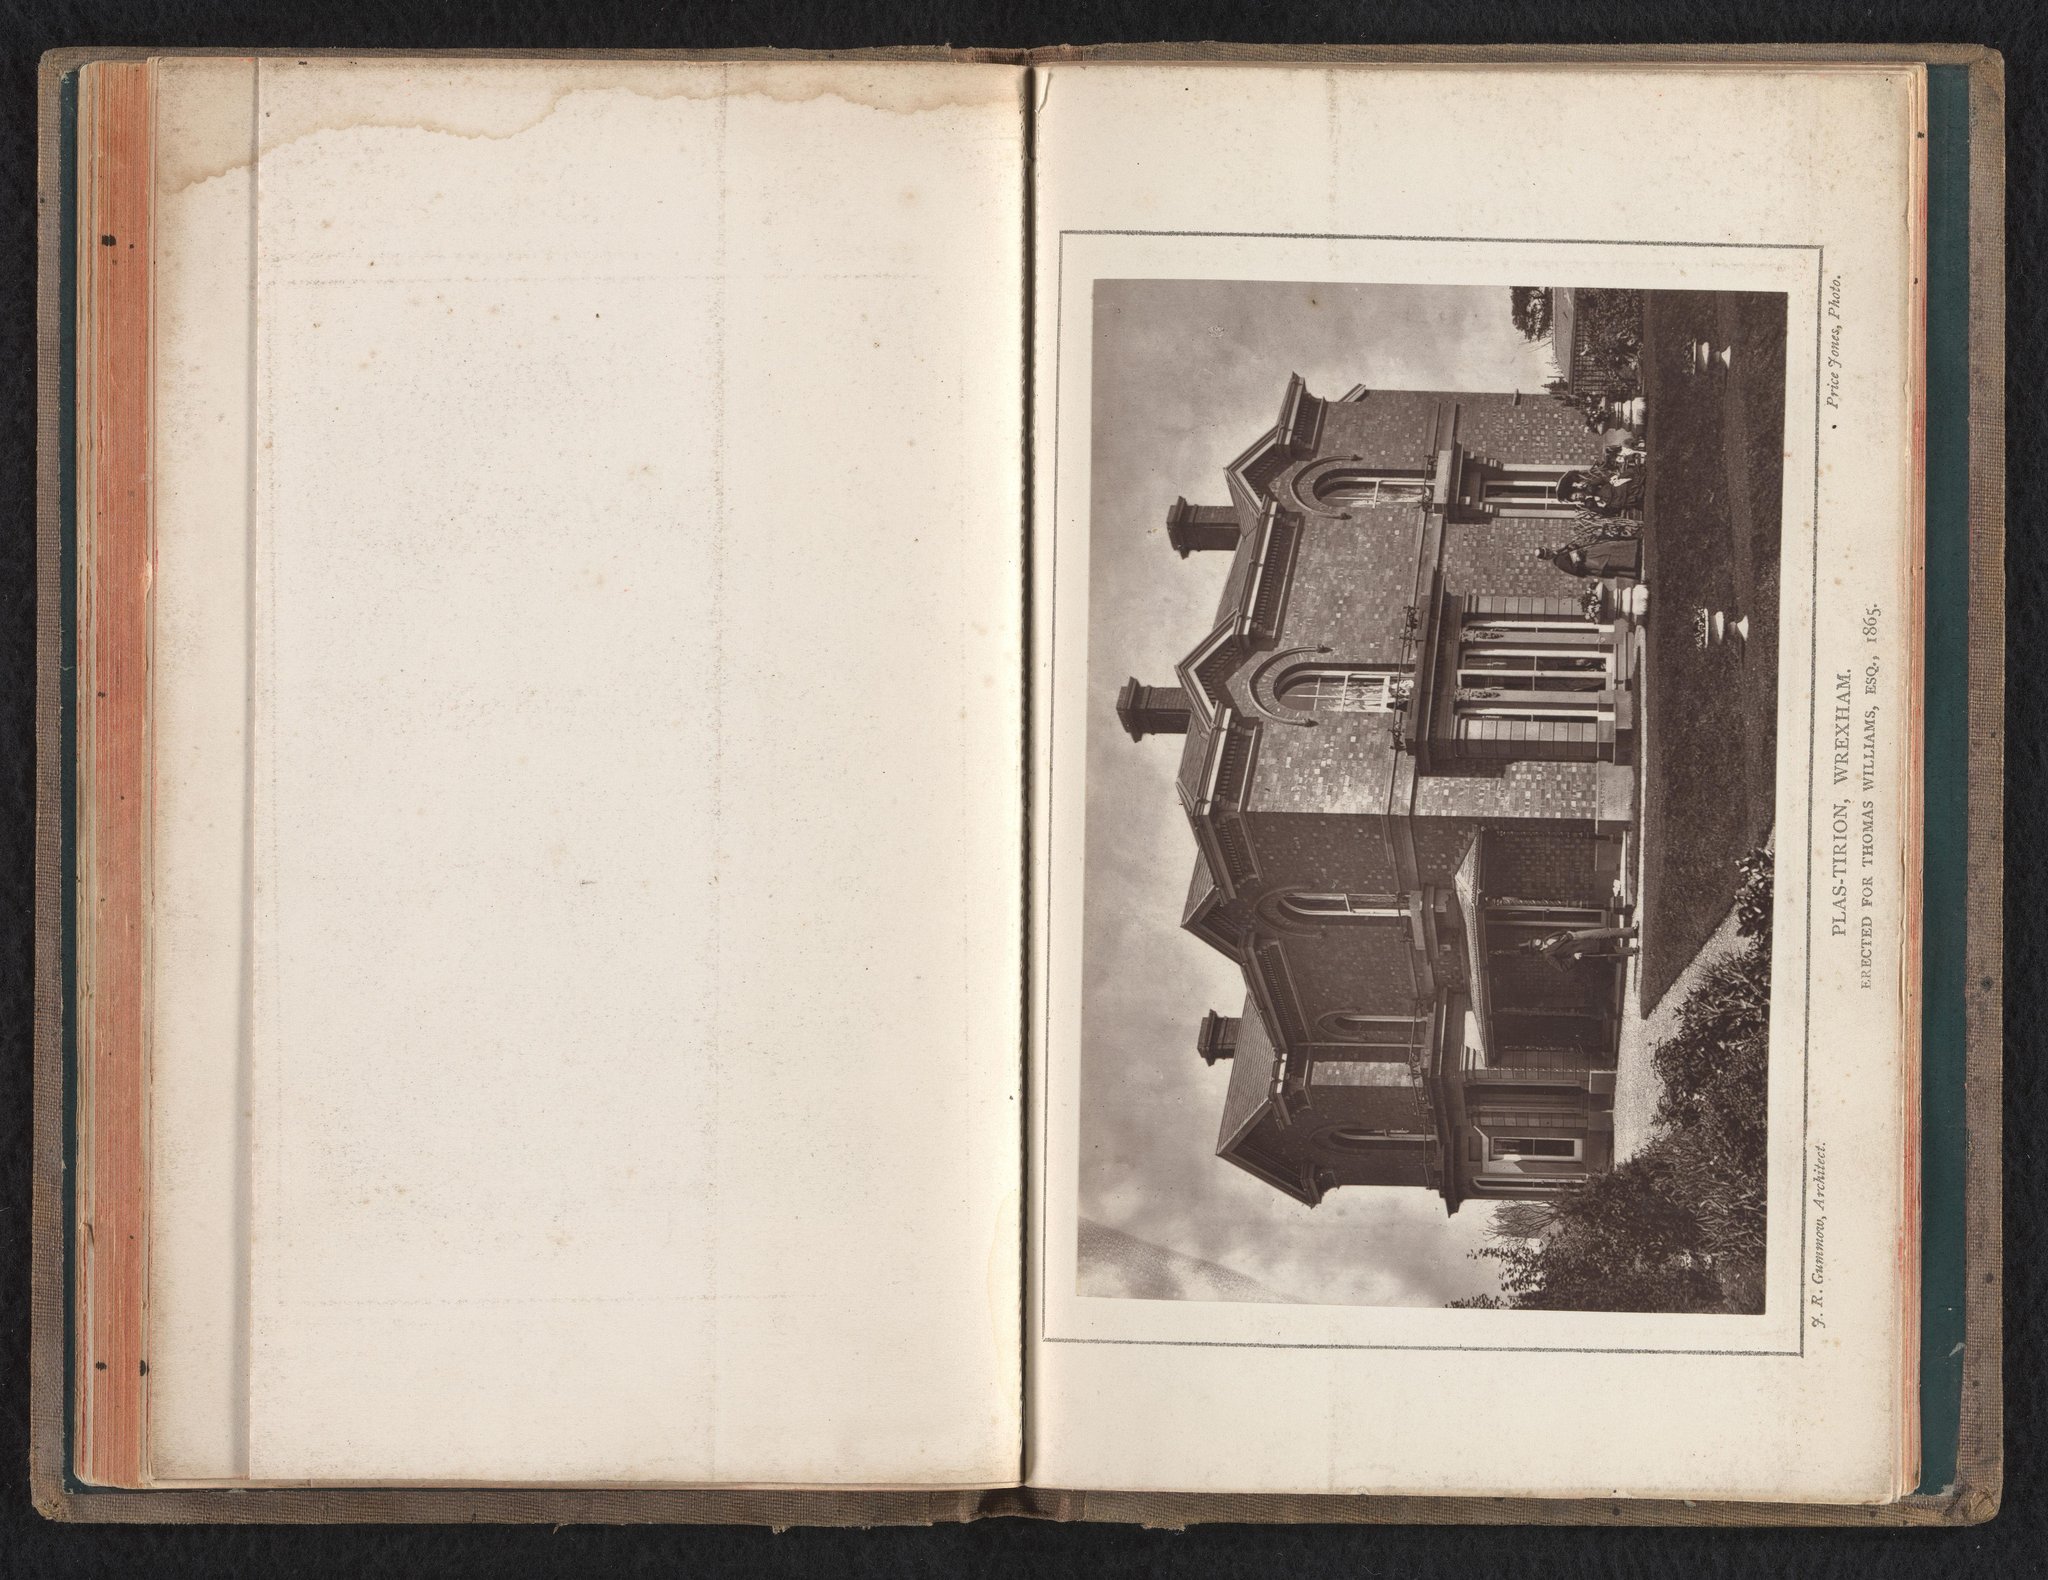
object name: photomechanical print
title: Plas-Tirion, Wrexham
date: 1865-1874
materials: paper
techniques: woodburytype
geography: wrexham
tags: garden, façade (of house or building)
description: Prent op achtste ongenummerde pagina na pagina 87.